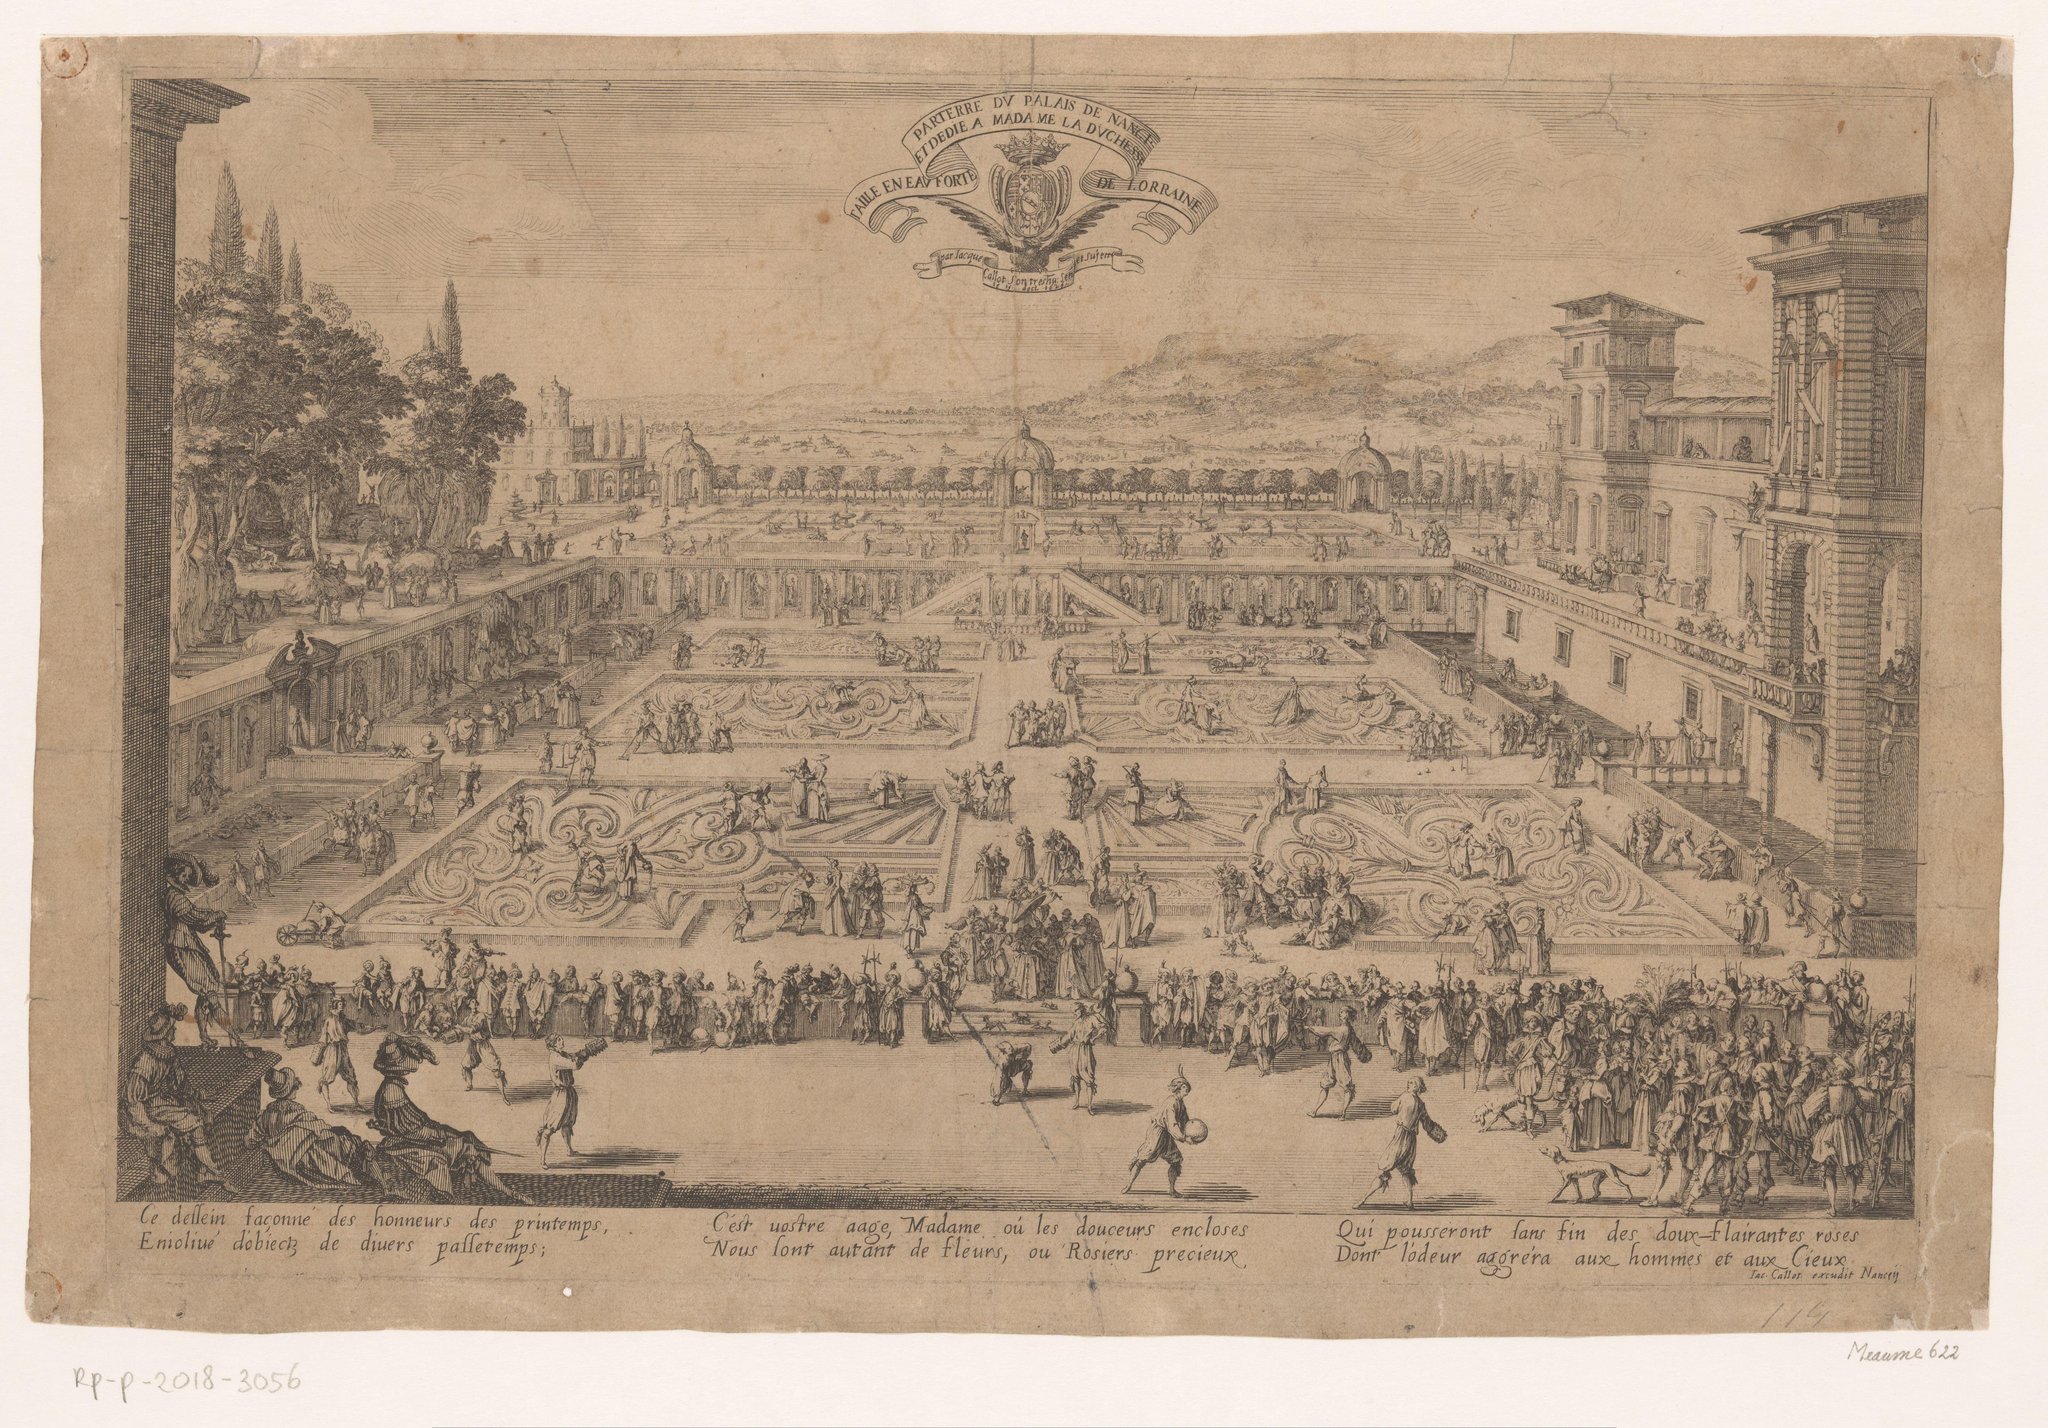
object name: print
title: Parterre du Palais de Nancy et dedie a madame la Duchesse de Lorraine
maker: jacques callot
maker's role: draughtsman, print maker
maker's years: 1592-1635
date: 1625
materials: paper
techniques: etching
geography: nancy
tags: palace, french or architectonic garden; formal garden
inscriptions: collector's mark: Lugt 2228